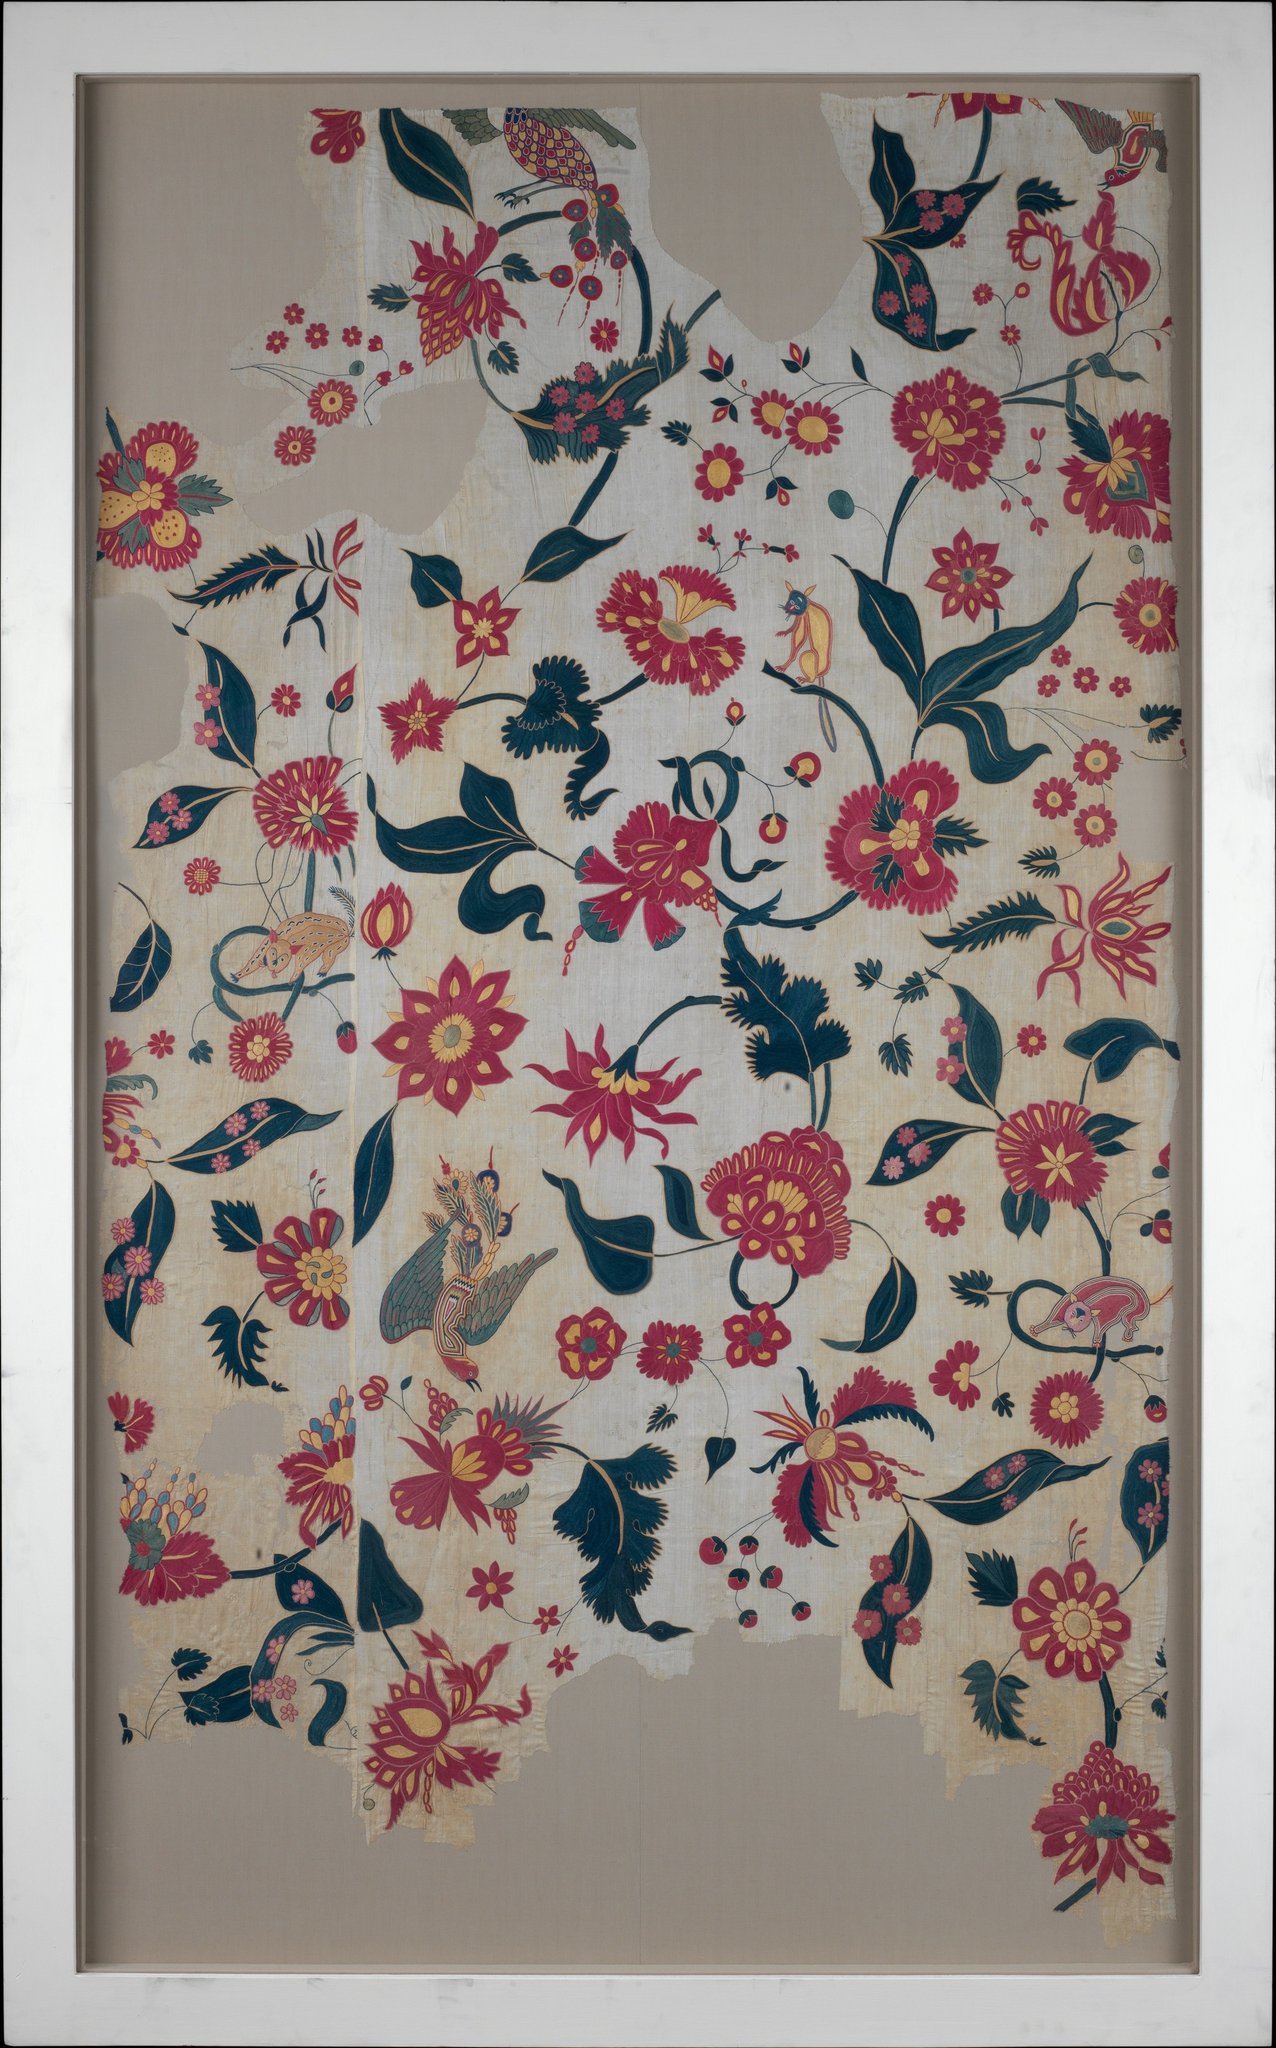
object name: hanging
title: Bed Cover or Wall Hanging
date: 1601-1700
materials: cotton, silk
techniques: embroidery, weave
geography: india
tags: flowers